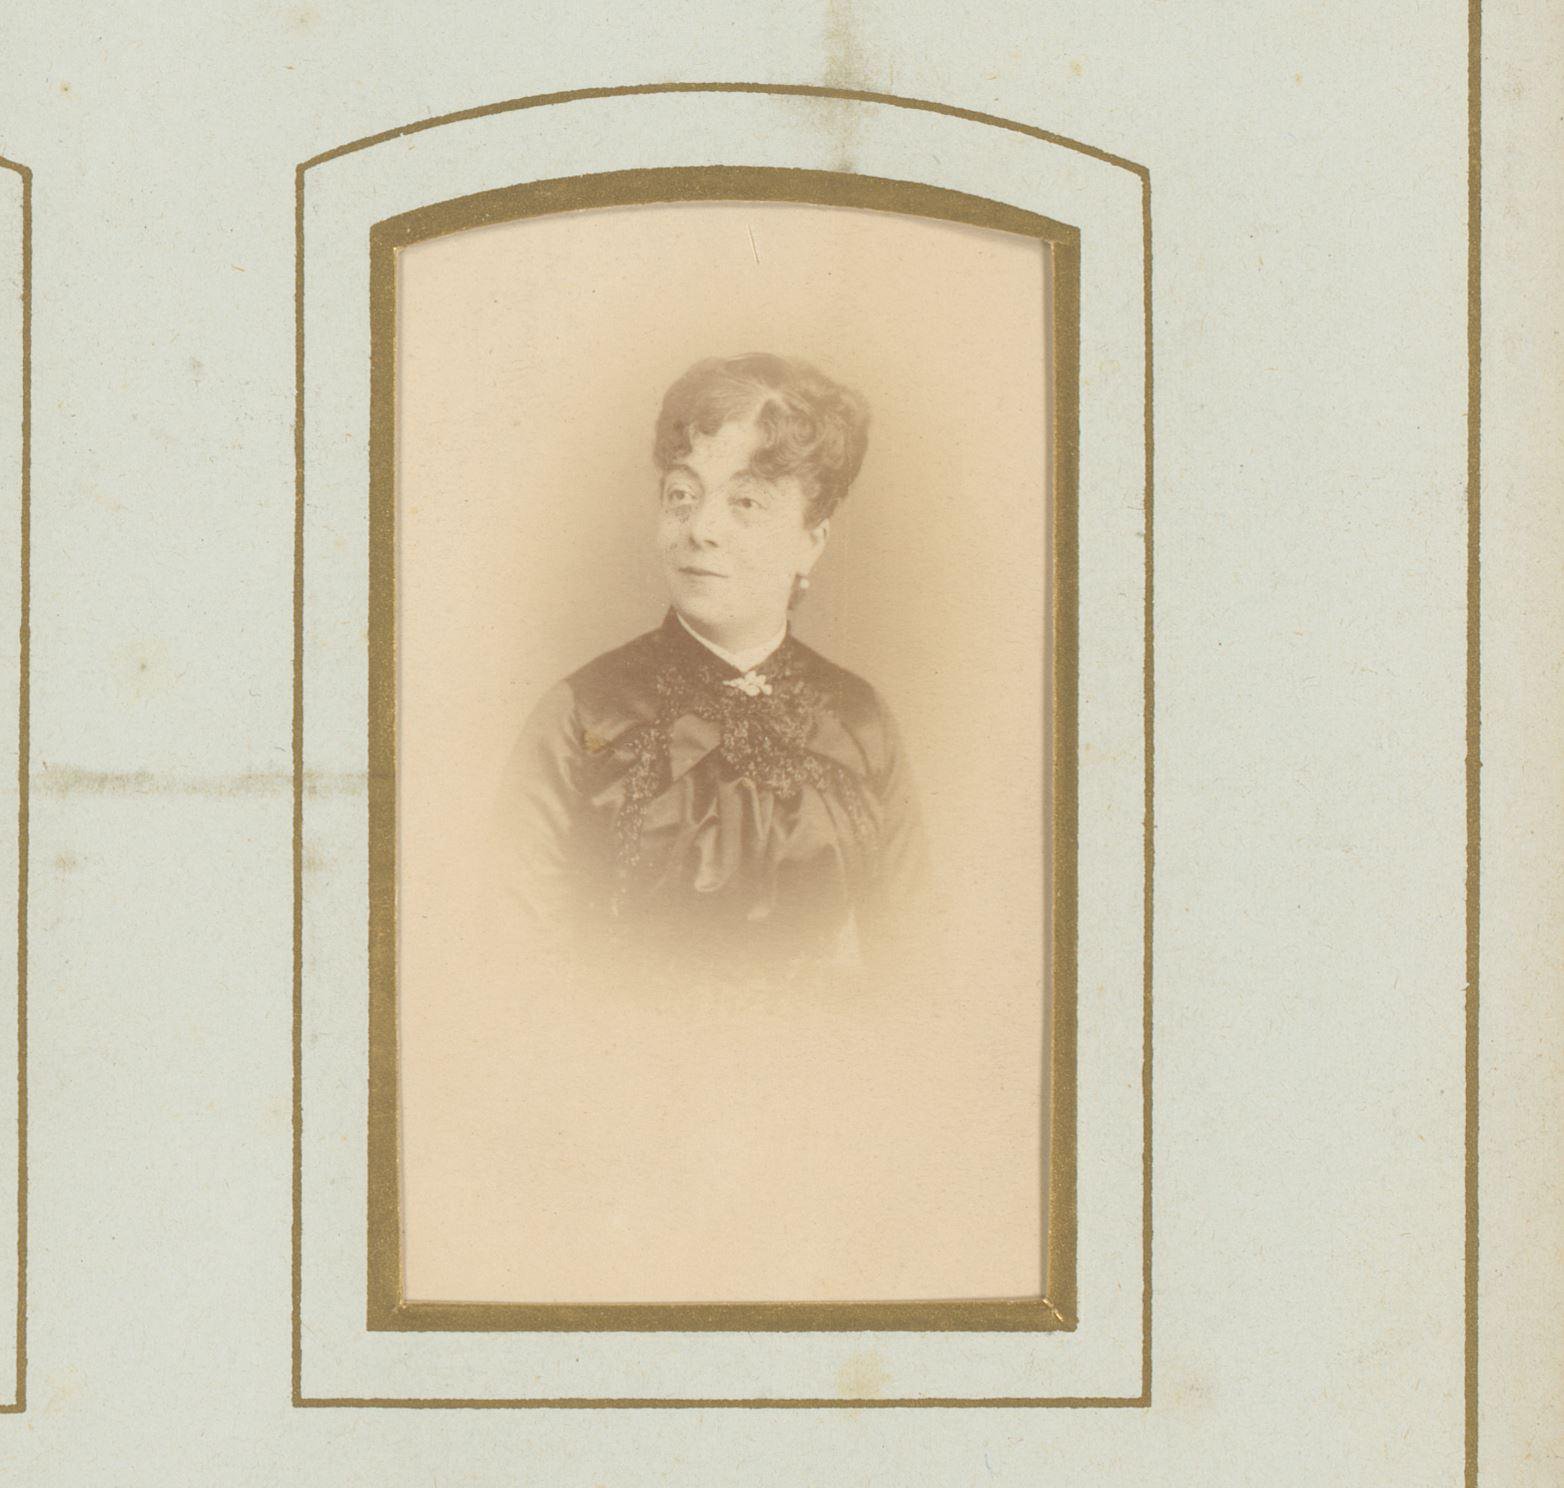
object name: album leaf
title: Portret van een vrouw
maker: pierre séraphin ciaïs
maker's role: fotograaf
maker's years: 1855-1886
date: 1850-1900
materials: cardboard, photographic support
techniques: albumen print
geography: nice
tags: historical persons - bb - woman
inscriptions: inscription: ‘Ciaïs/ PHOTOGRAPHE/ Boulevard du Pont neuf, 24/ NICE/ Les Clichés sont conservés./ No.’